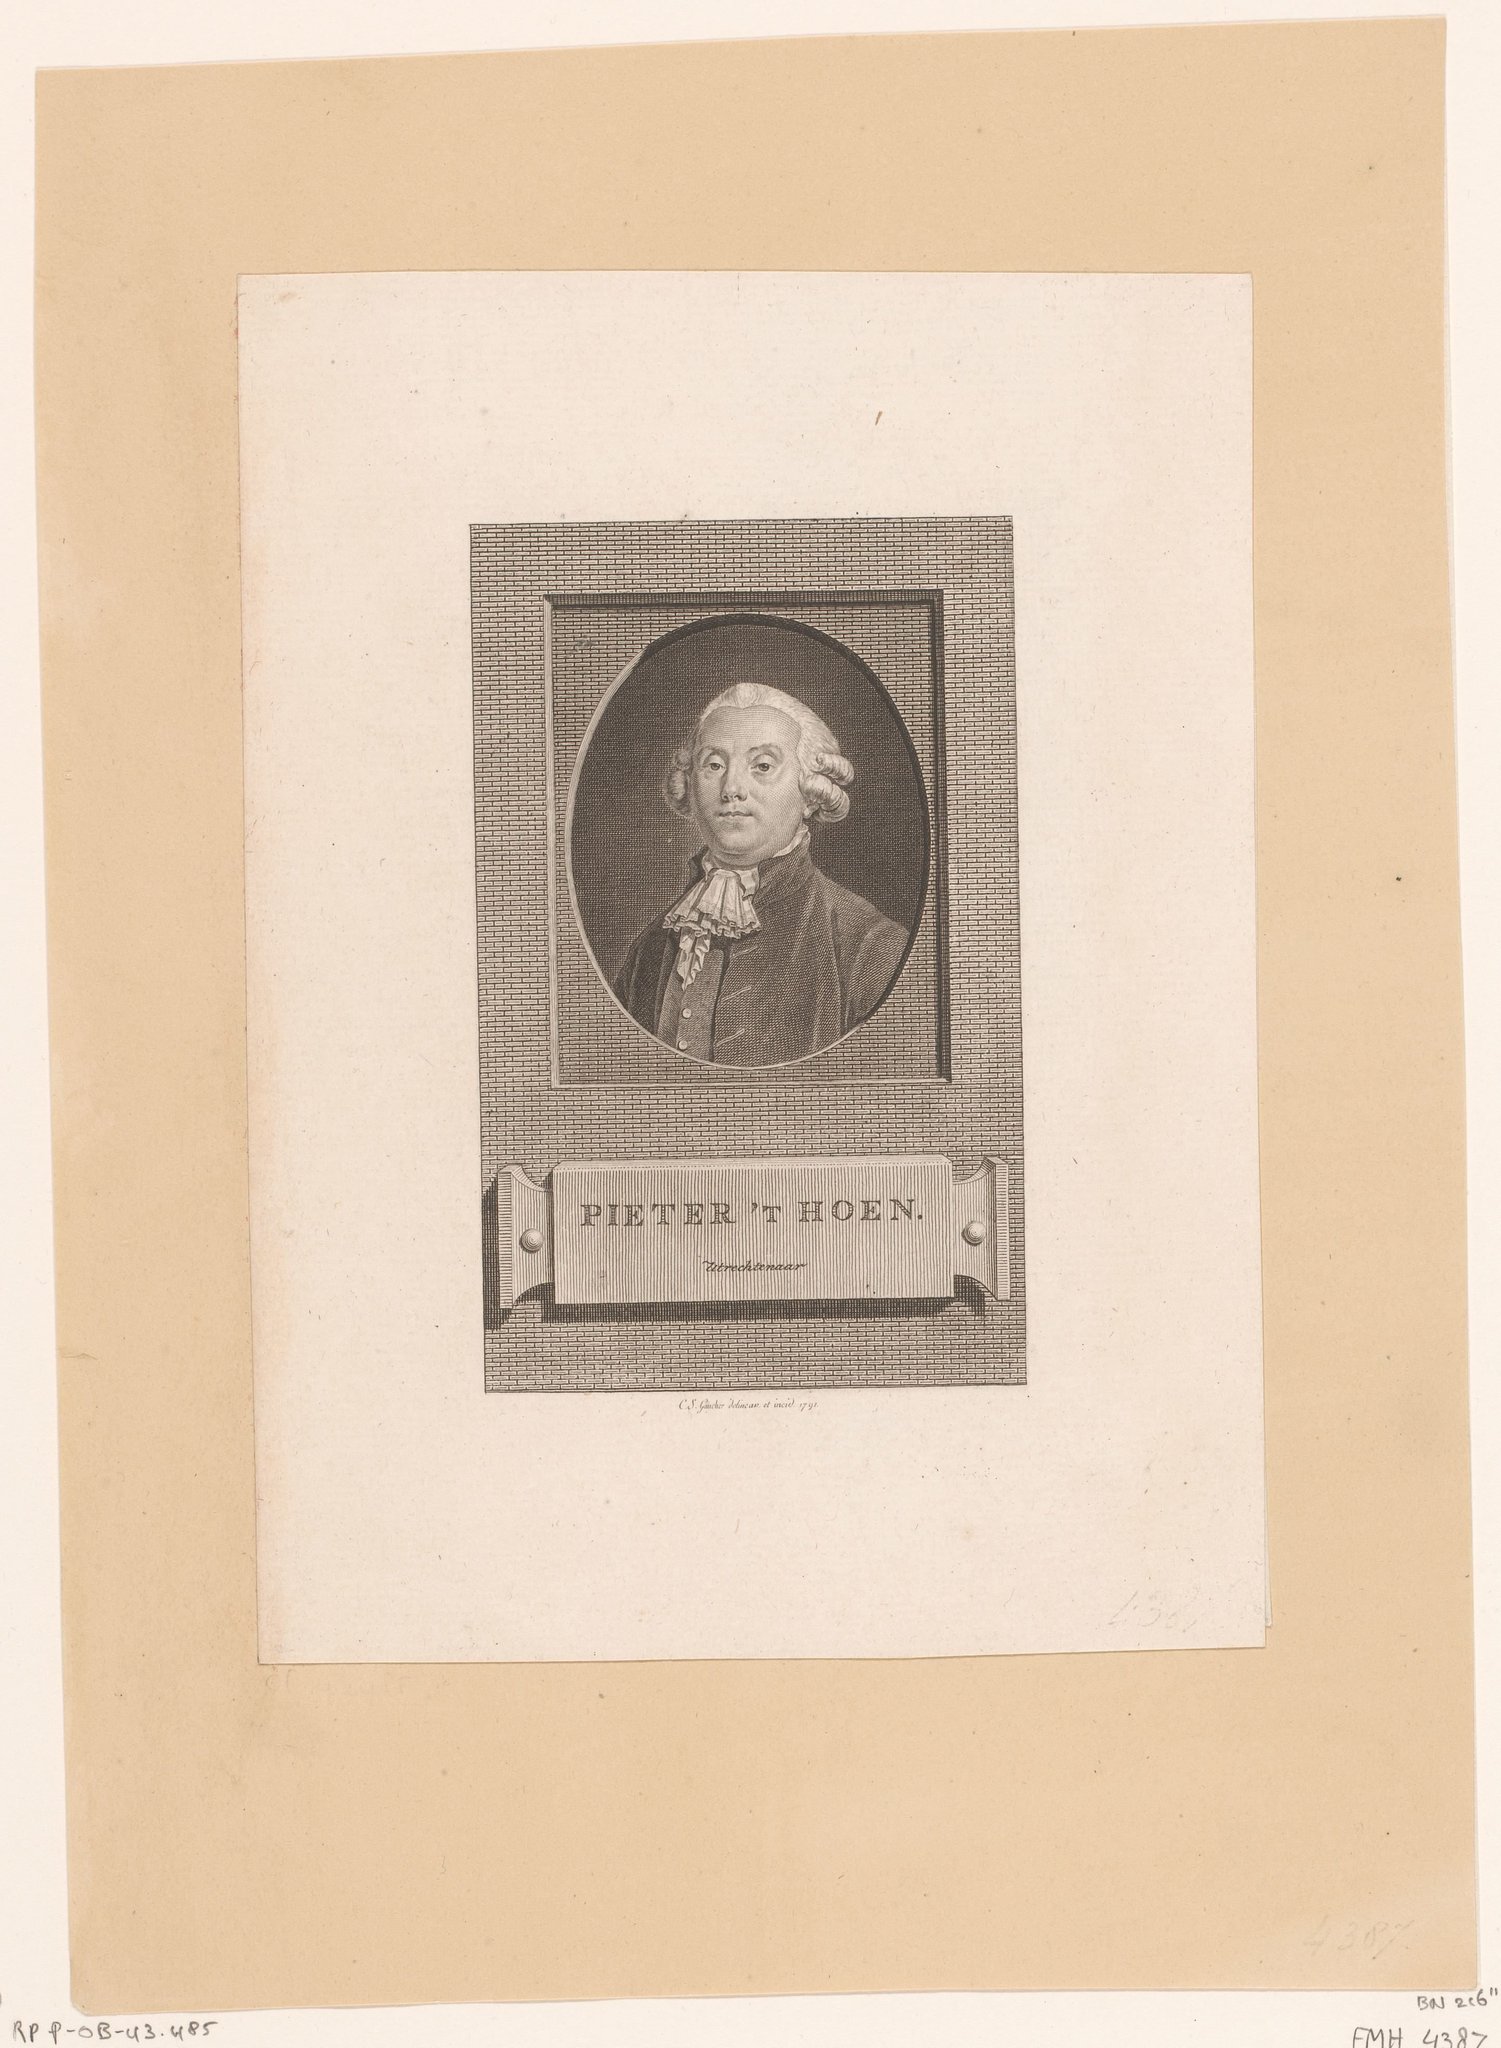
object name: print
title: Portret van Pieter 't Hoen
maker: charles etienne gaucher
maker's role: print maker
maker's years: 1741-1804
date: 1791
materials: paper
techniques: engraving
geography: france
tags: pieter 't hoen, ornament ~ medallion, historical persons, patriots (1780-1795)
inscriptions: collector's mark: Lugt 2228